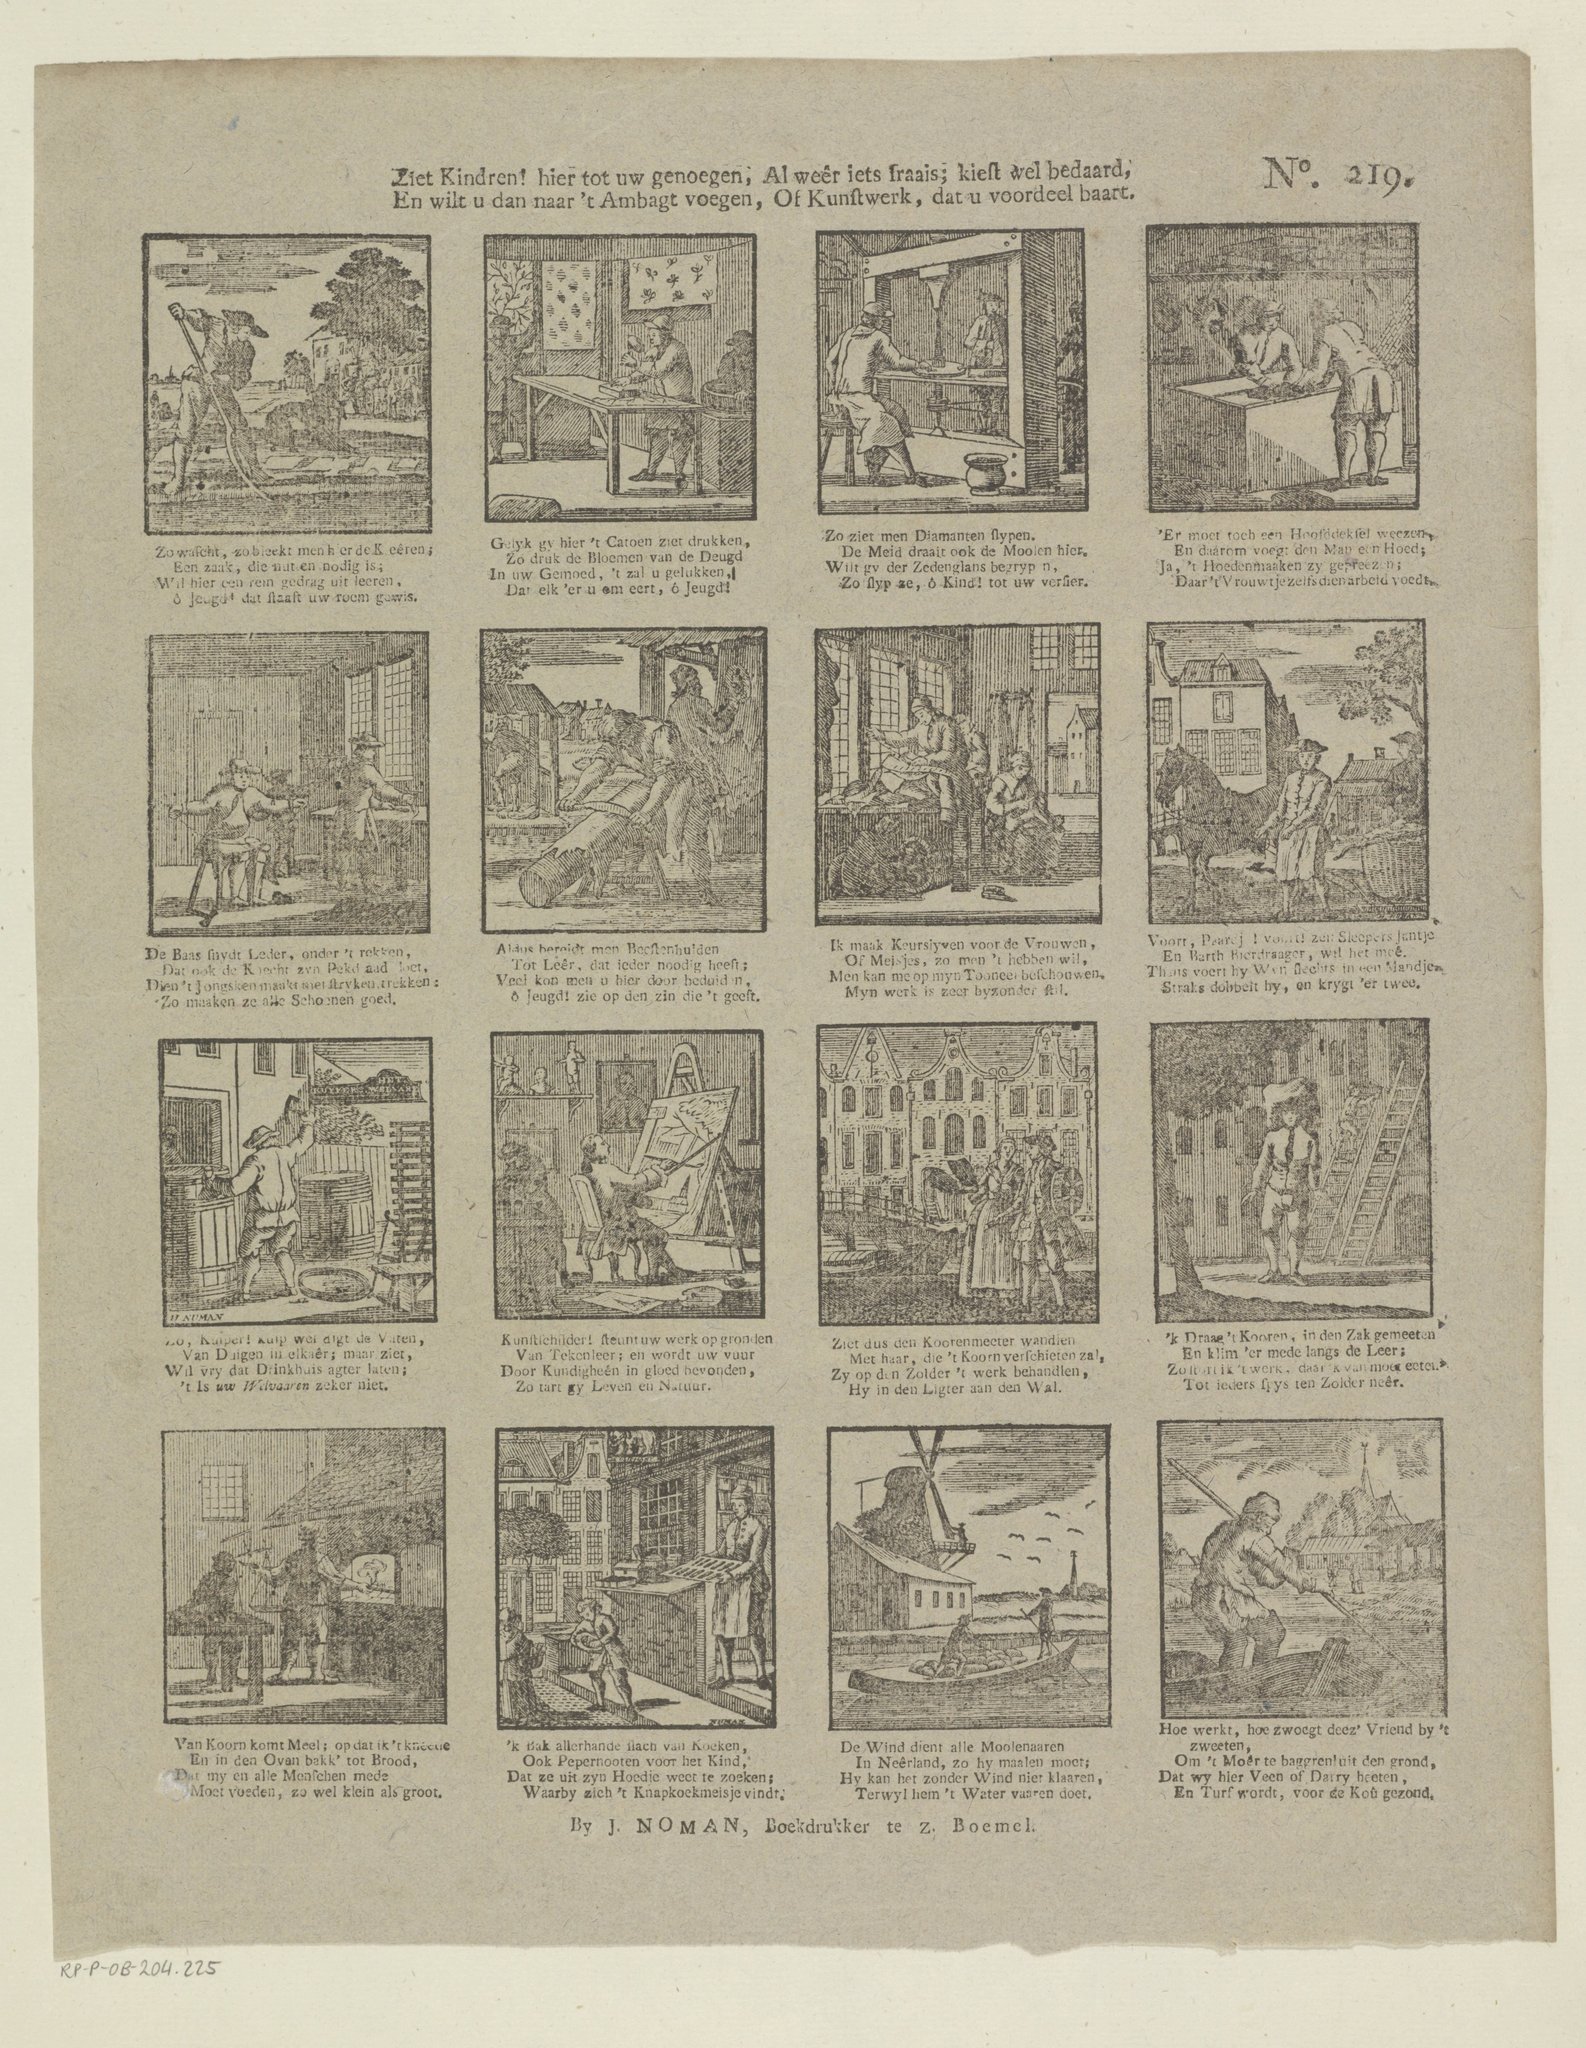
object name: popular print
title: Ziet kindren! hier tot uw genoegen, Al weêr iets fraais; kiest wel bedaard, / En wilt u dan naar 't ambagt voegen, Of kunstwerk, dat u voordeel baart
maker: johan noman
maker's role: printer, publisher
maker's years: -1833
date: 1806-1830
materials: paper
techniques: letterpress printing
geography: zaltbommel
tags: diamond polisher, diamond cutter, craft-production, skilled handiwork, painter at work, in his studio, baker, crafts and industries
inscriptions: collector's mark: Lugt 2760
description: Blad met 16 voorstellingen van ambachtslieden en beroepen, zoals diamantslijper, hoedenmaker, kuiper en bakker. Onder elke voorstelling een vierregelig vers. Genummerd rechtsboven: No. 219.